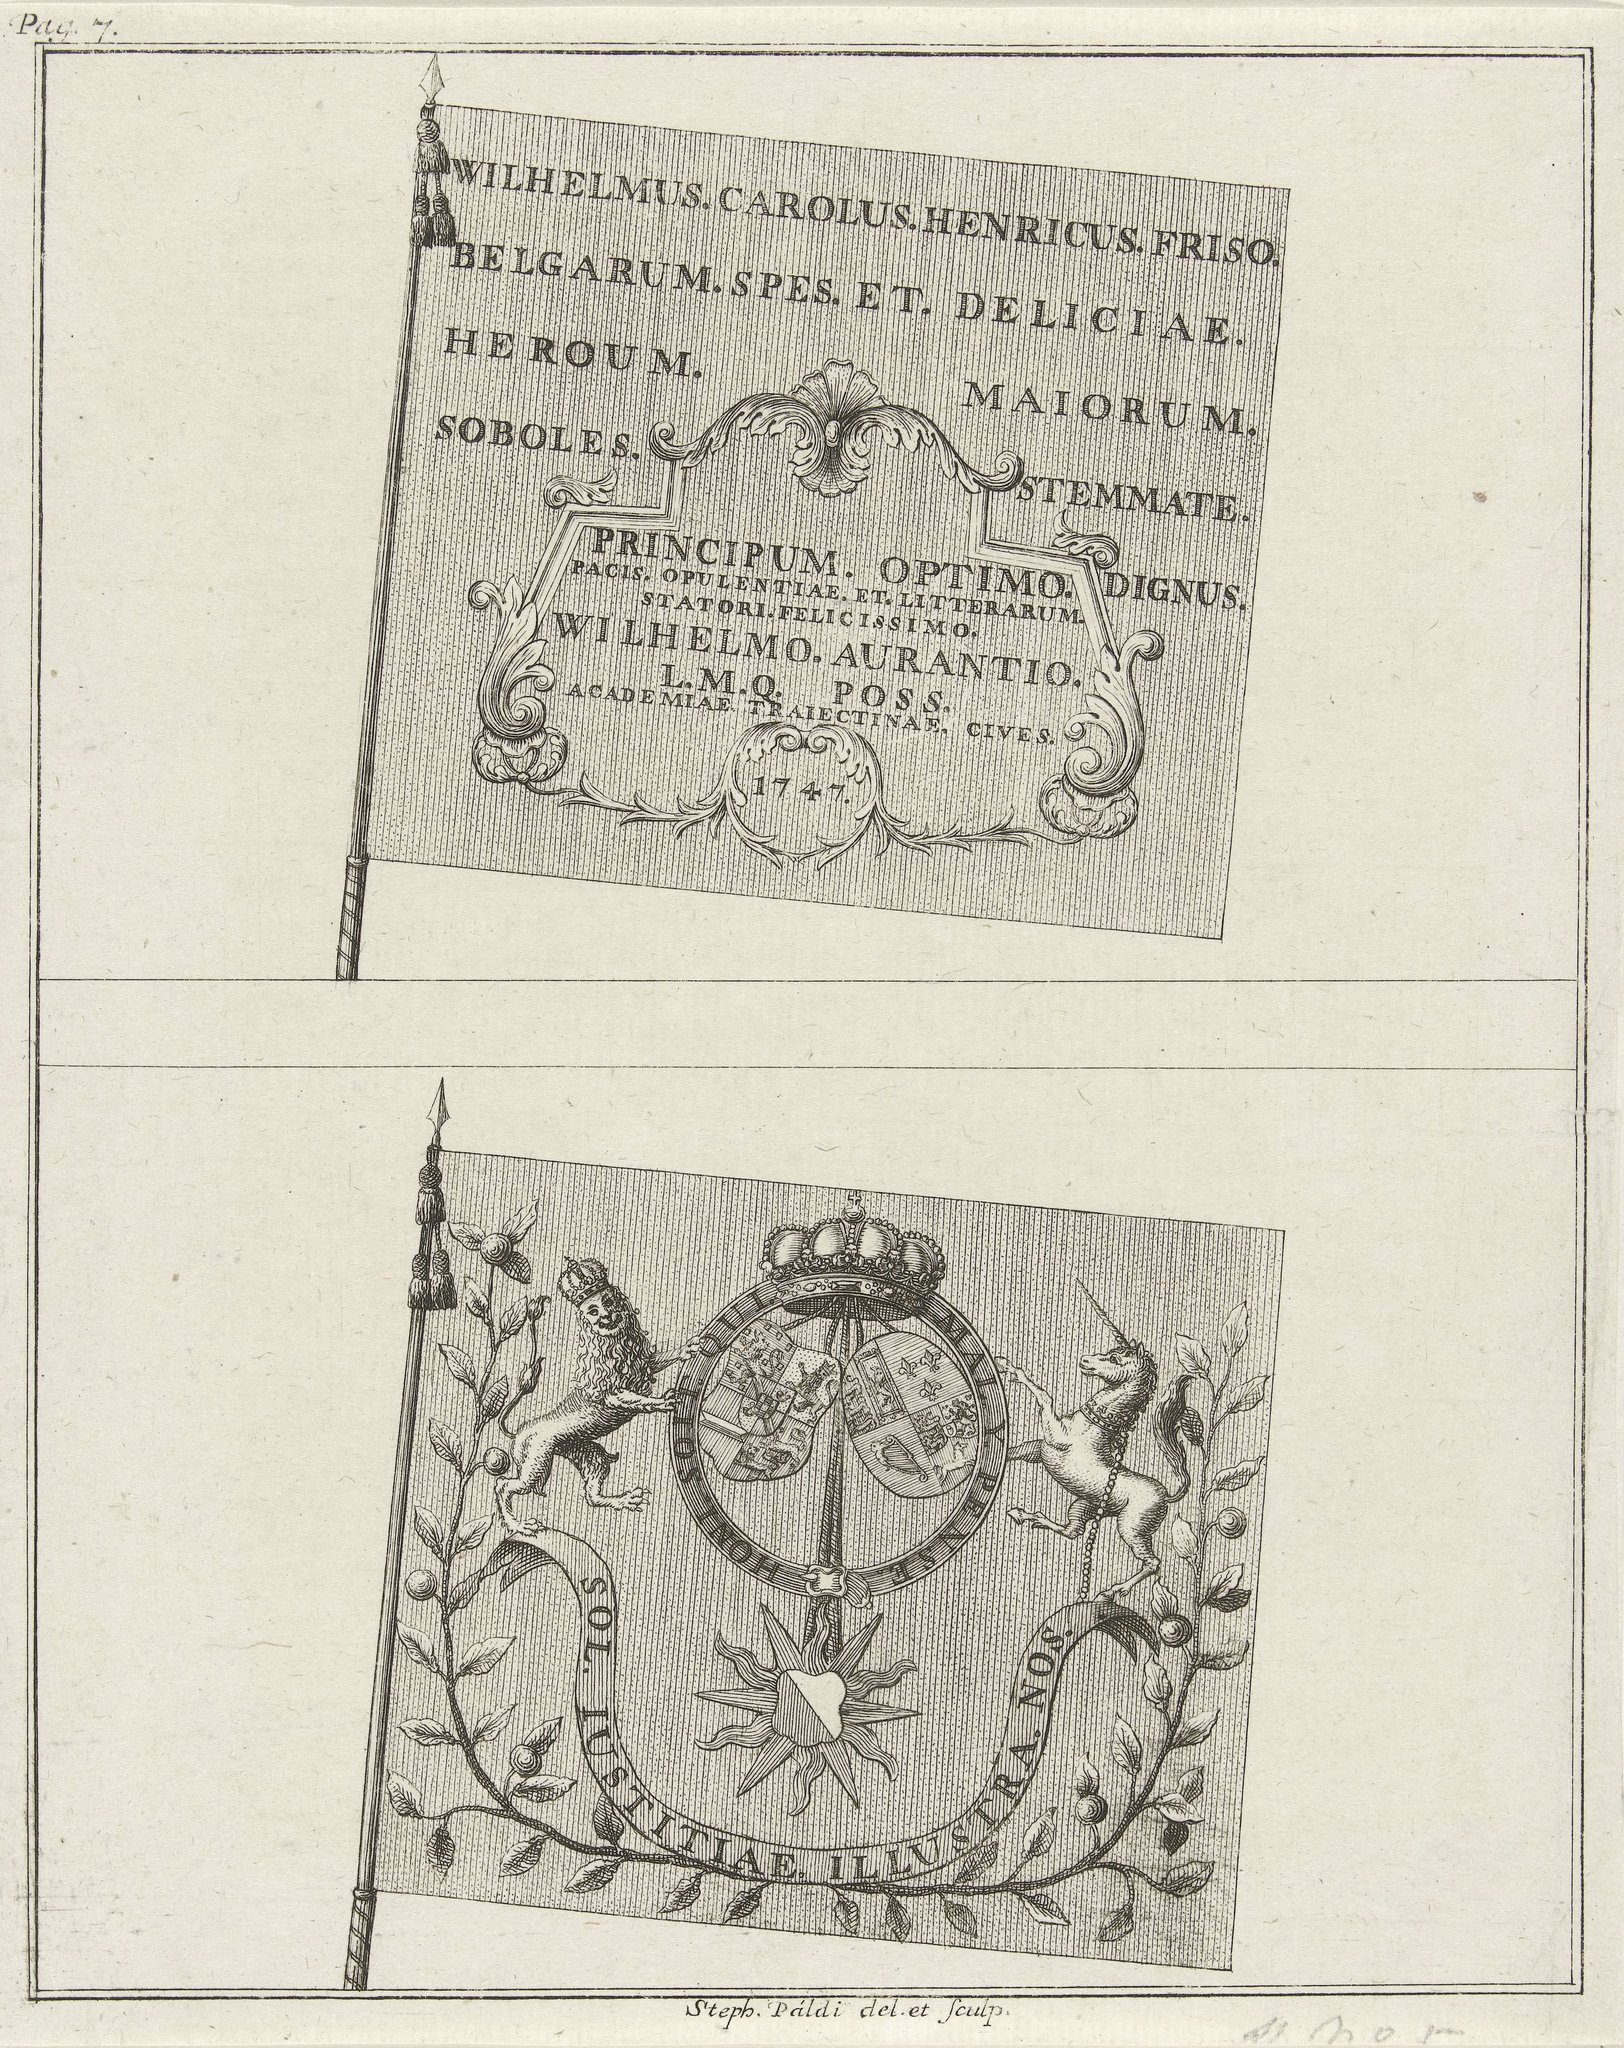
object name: print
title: Vaandel van de Utrechtse studenten ter ere van Willem IV, 1747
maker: istván páldi székely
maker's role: printer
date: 1747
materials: paper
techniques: engraving, etching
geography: northern netherlands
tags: the hague, willem iv (prins van oranje-nassau), banner, standard (as symbol of the state, etc.), utrecht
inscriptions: collector's mark: Lugt 2228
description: Gebruikt als illustratie in: Een liefhebber van Utrechts Akademie [= Marten Schagen]. Naeuwkeurige beschryving van alles wat de heeren studenten der Utrechtsche hooge schole verrigt hebben (...) by de (...) inhuldiginge van (...) Wilhem Karel Henrik Friso (...) tot stadhouder. Utrecht: Hermanus en Johannes Besseling, 1747 (zie de beschrijving bij Atlas van Stolk nr. 3679).. Volgens Muller gebruikt als illustratie in: Arnoldus Lobedanius. Beschryving der vreugde-blyken, illuminatien, decoratien, devisen, inscriptien, enz. Die ter gelegenheid van de installatie van (...) den here prinse van Orange (...) tot stadhouder (...) te zien geweest zyn. Utrecht: Arnoldus Lobedanius, 1747.